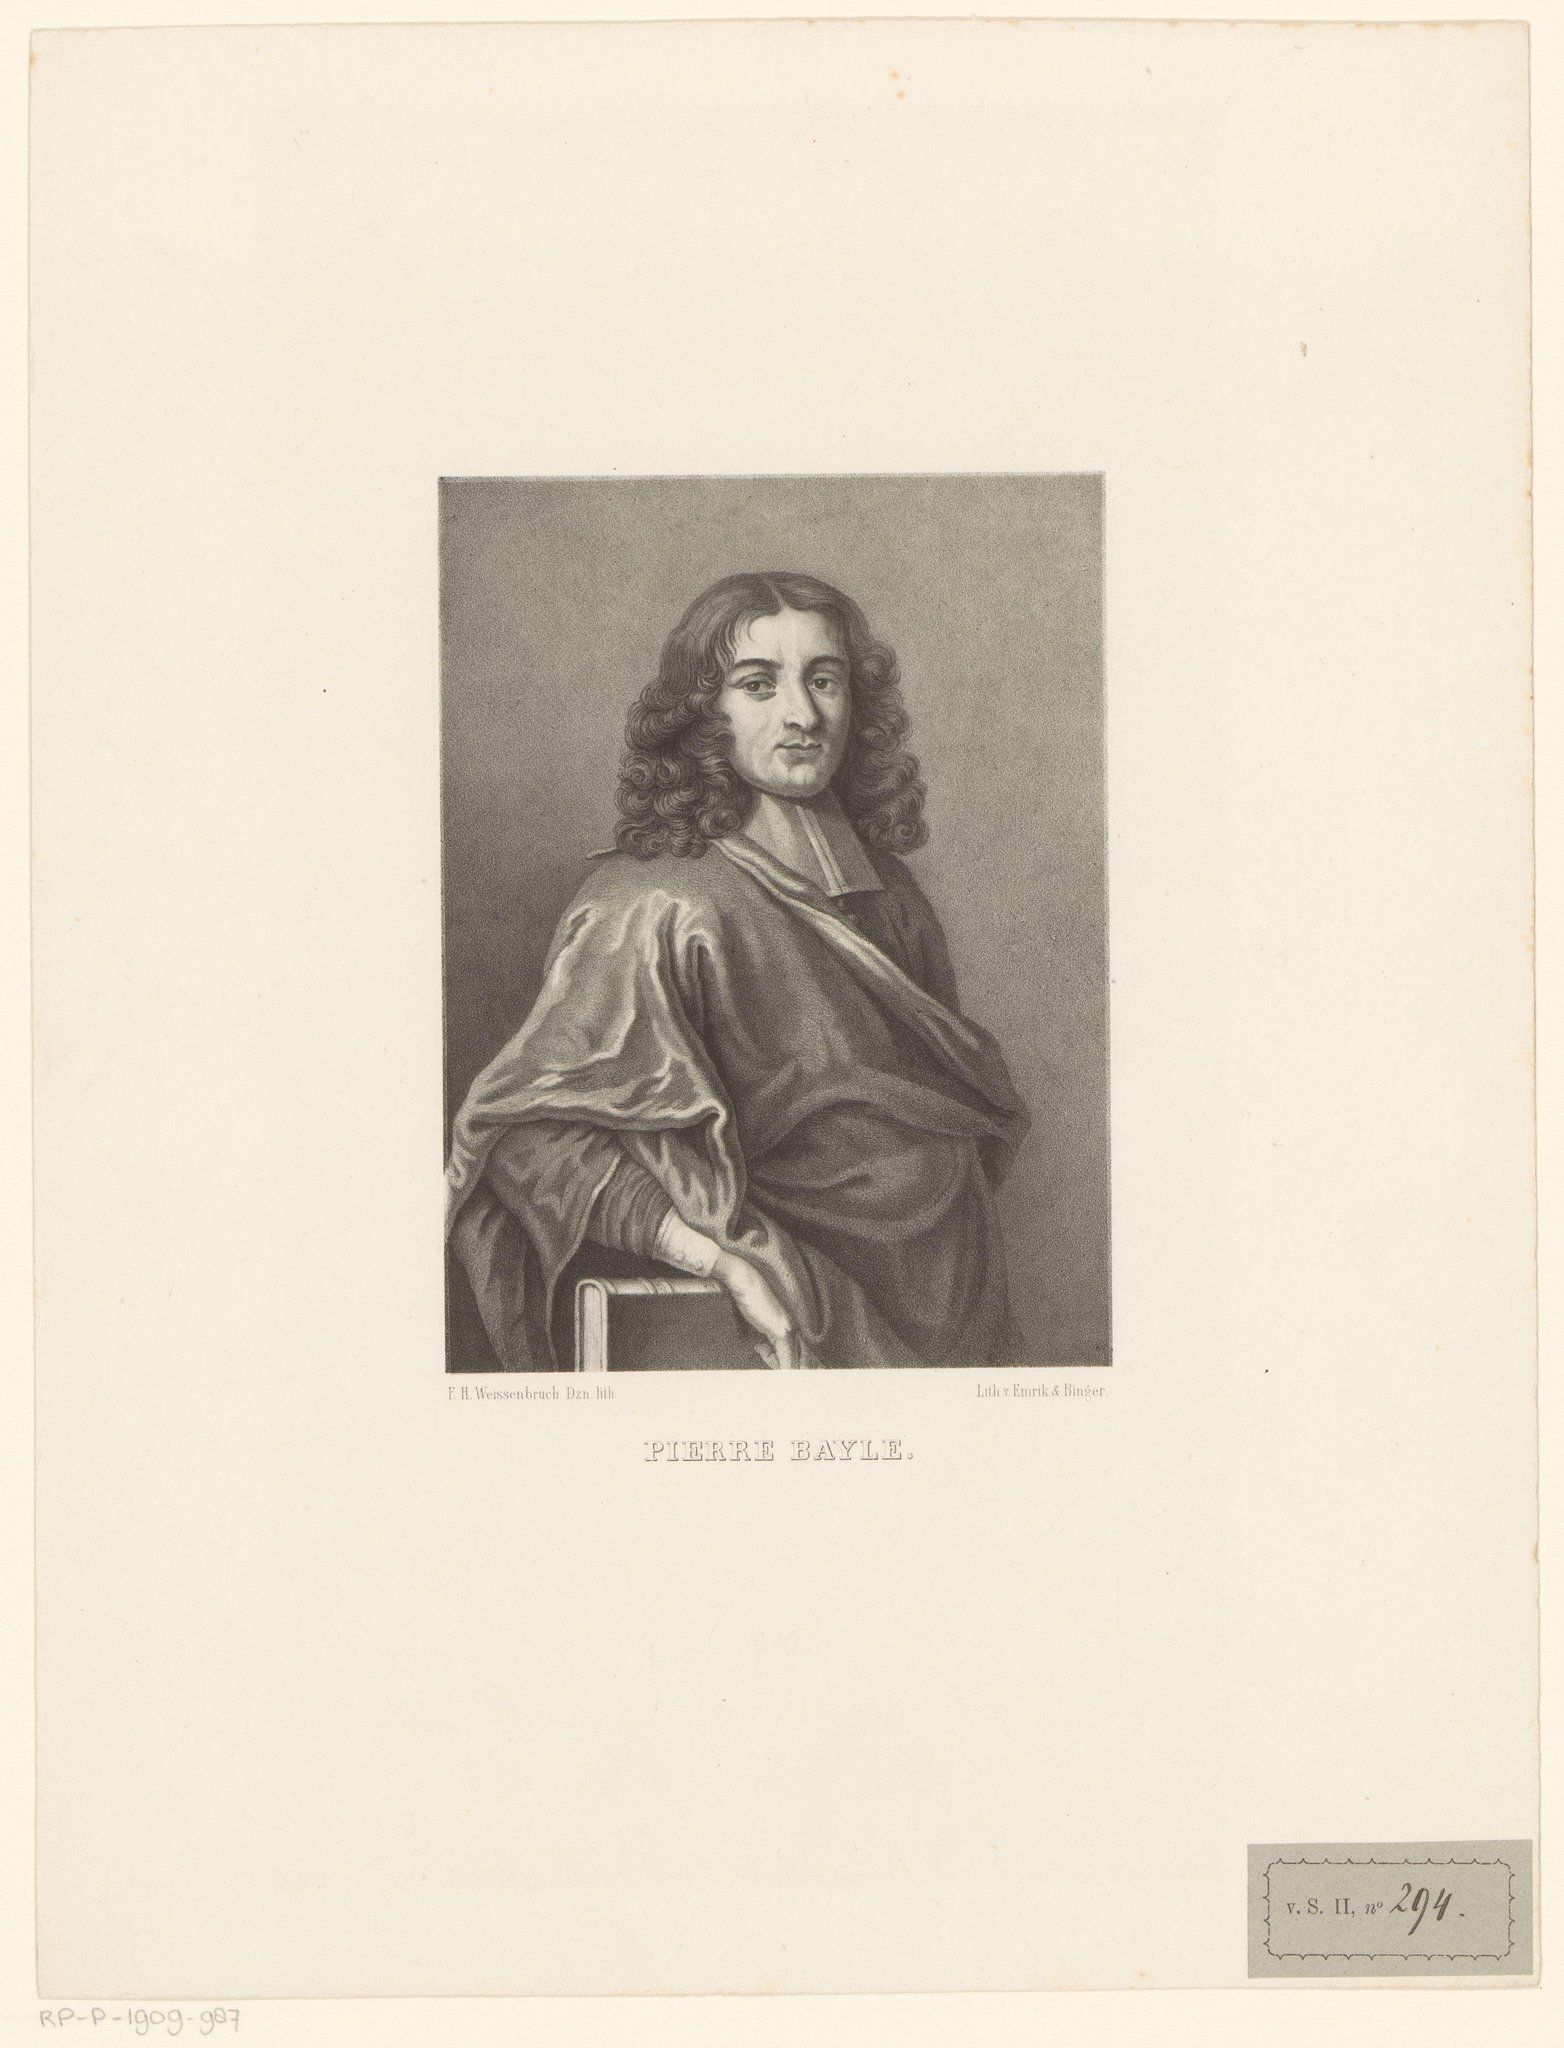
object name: print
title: Pierre Bayle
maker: frederik hendrik weissenbruch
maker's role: draughtsman, print maker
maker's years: 1828-1887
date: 1857-1887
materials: paper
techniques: lithograph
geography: haarlem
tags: rotterdam, historical persons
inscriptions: collector's mark: Lugt 2228